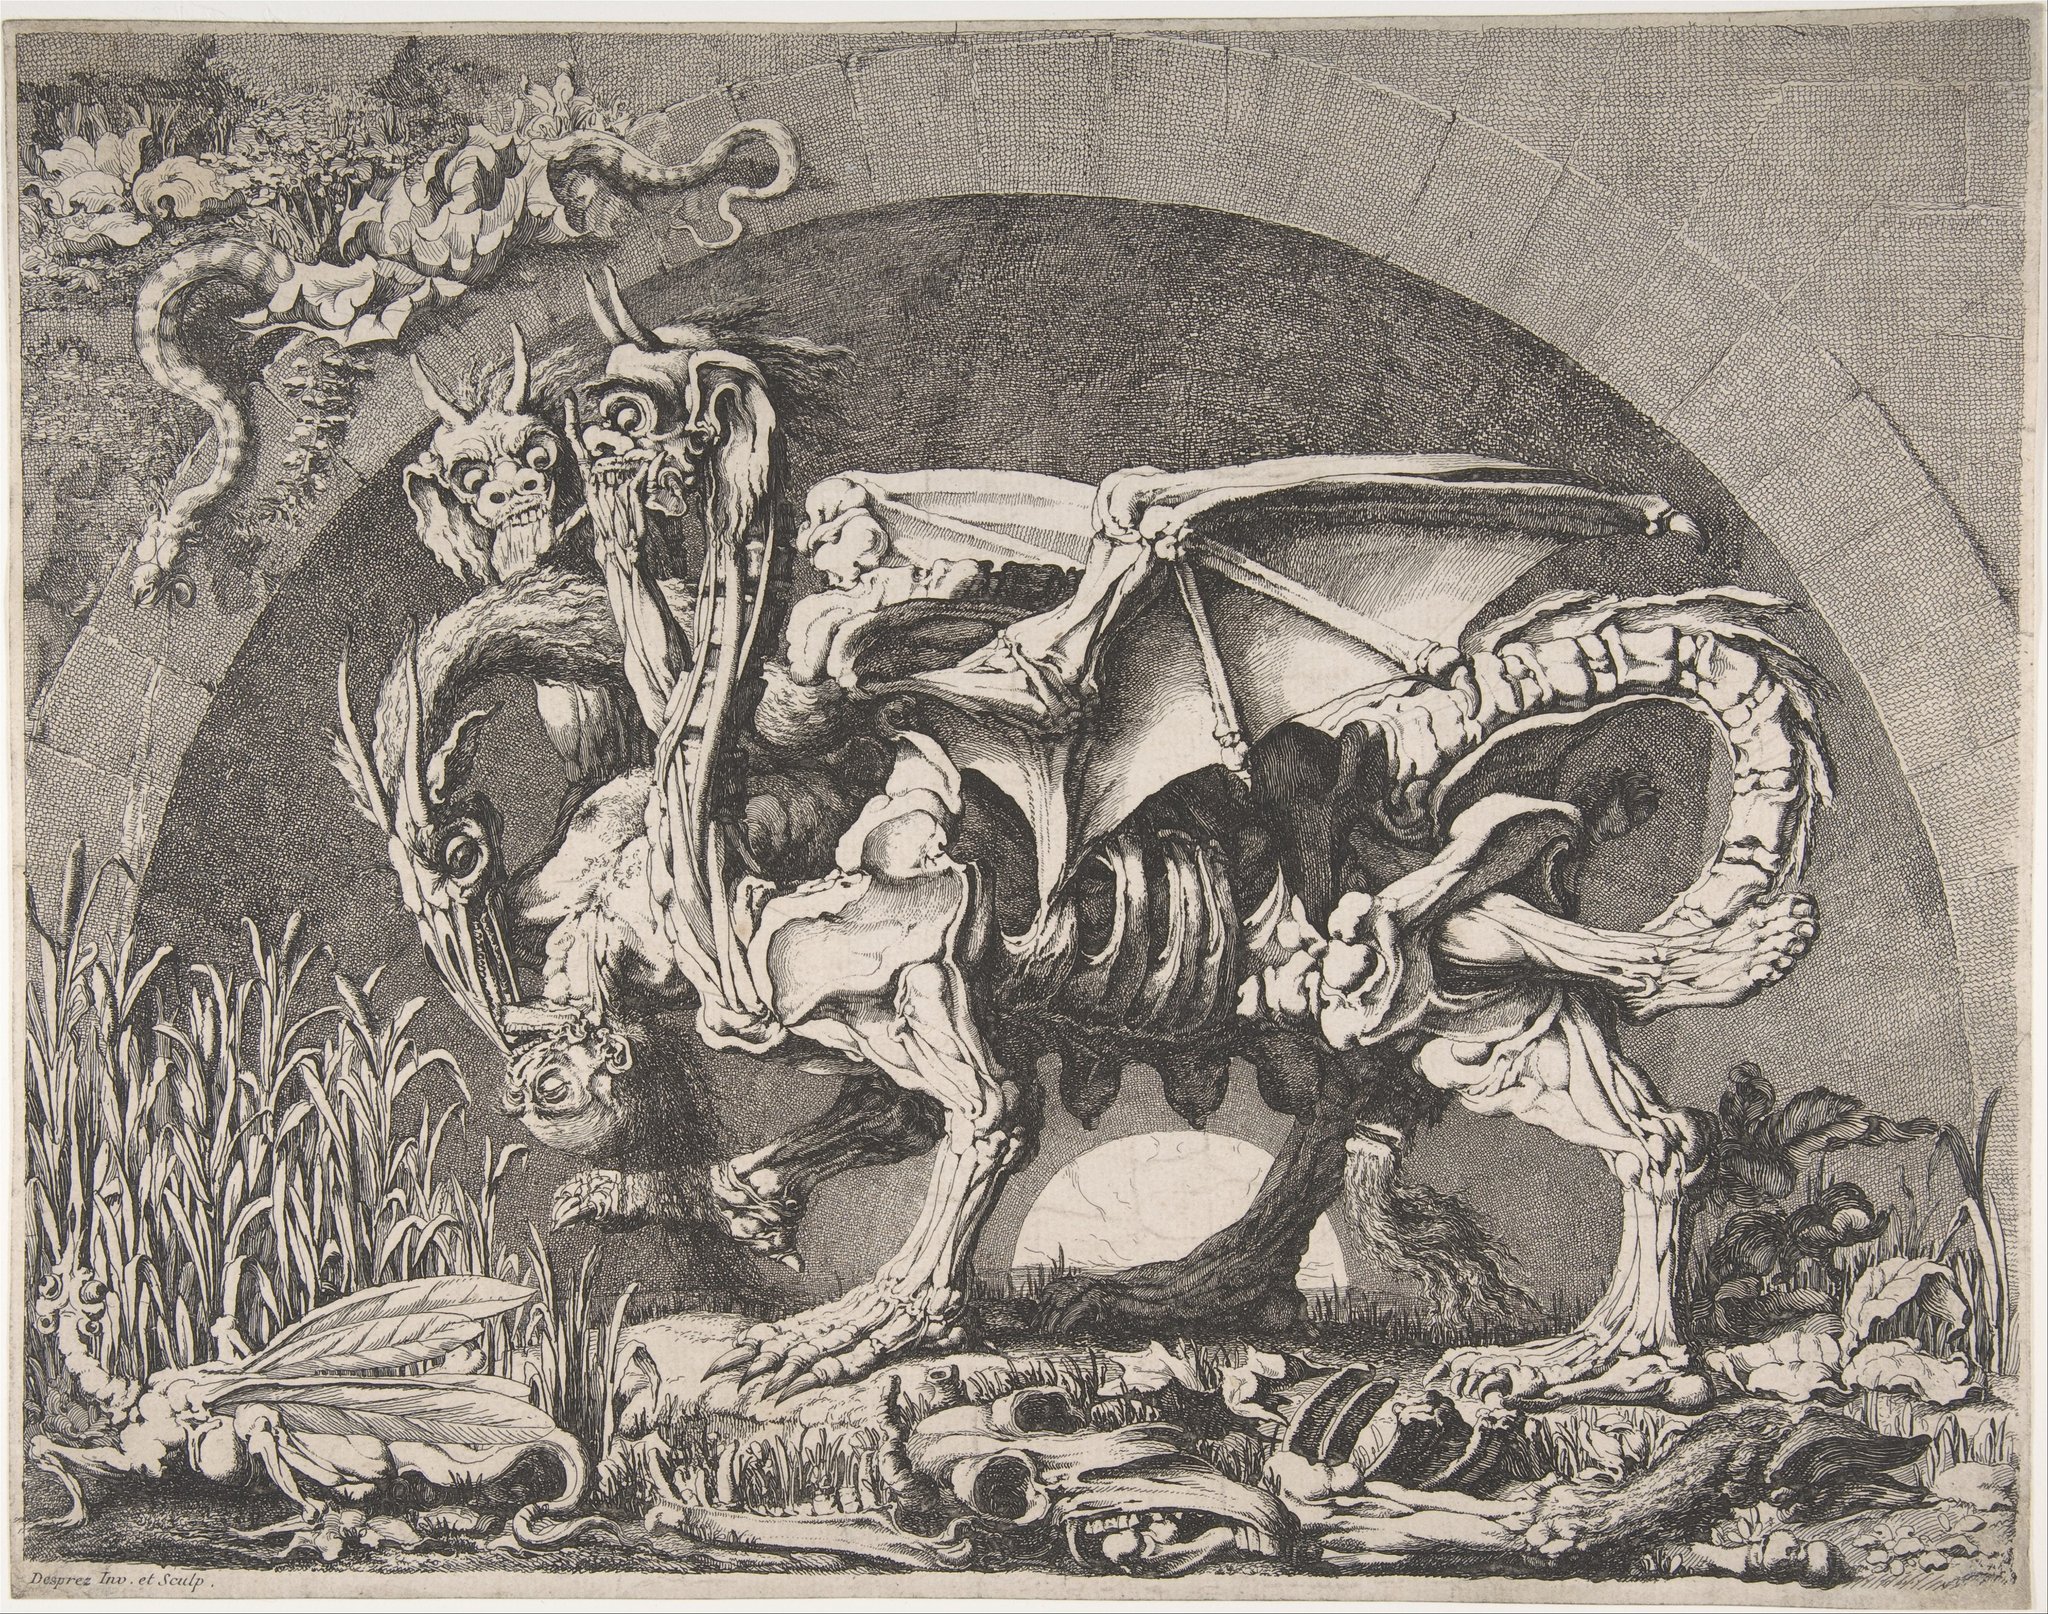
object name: print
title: The Chimera (La Chimère de Monsieur Desprez)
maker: louis jean desprez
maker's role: artist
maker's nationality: french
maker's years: 1743-1804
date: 1777-1784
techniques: etching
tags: plants